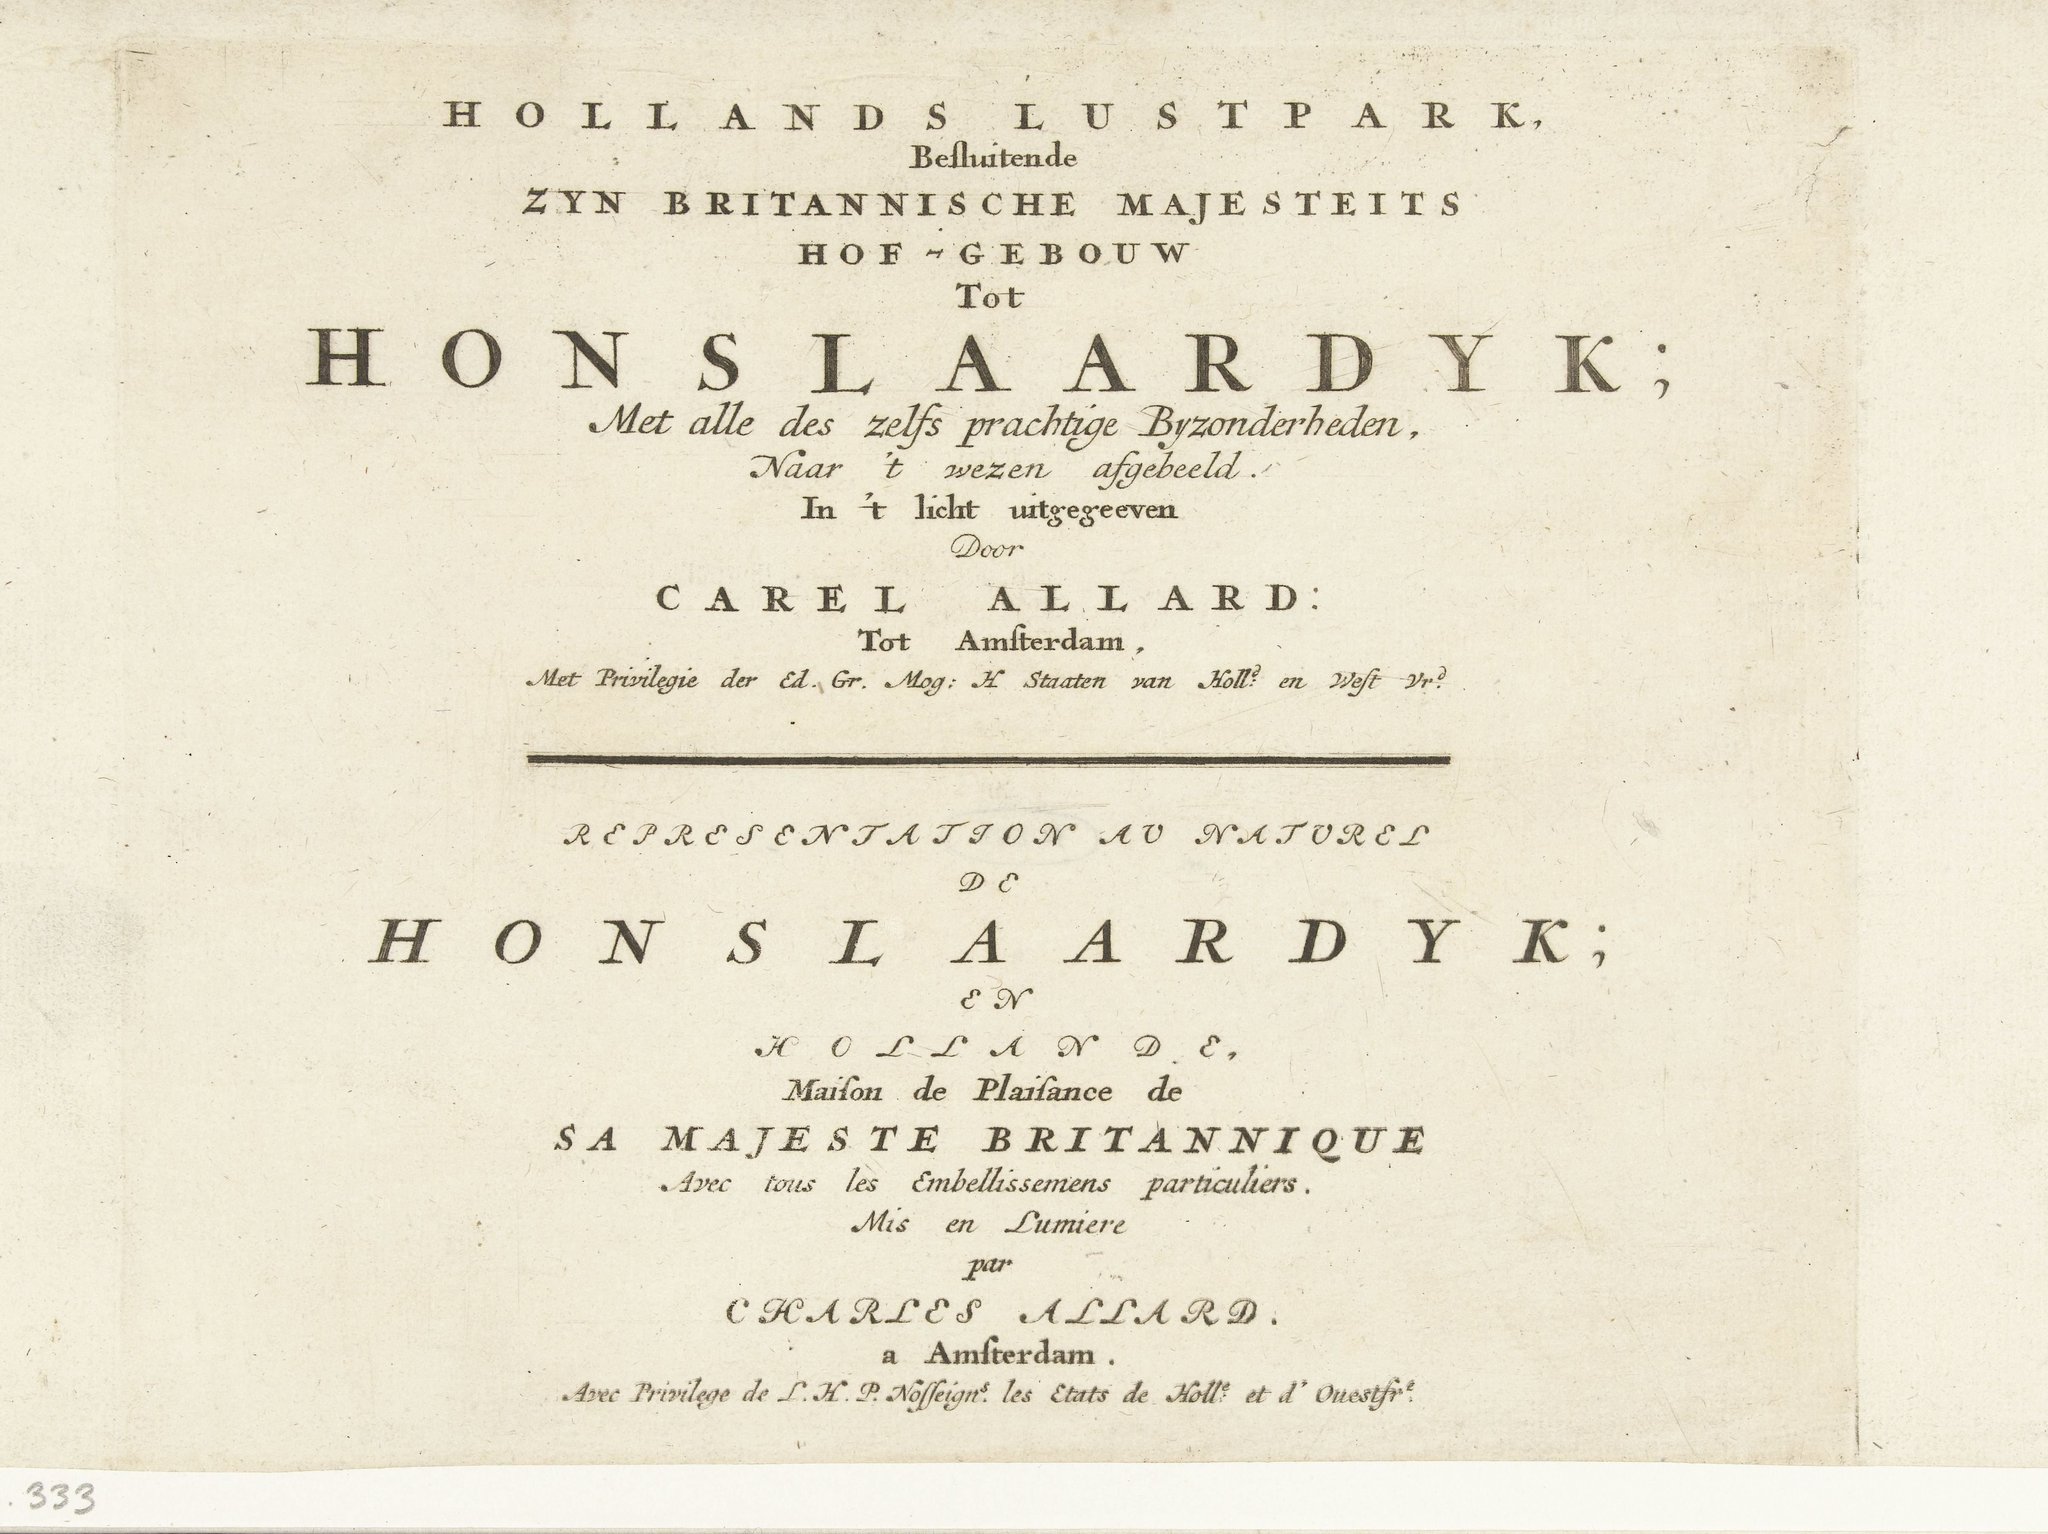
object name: print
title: Titelpagina voor Hollands Lustpark van Carel Allard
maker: carel allard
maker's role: print maker, publisher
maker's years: 1648-1709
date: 1673-1709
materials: paper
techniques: etching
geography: amsterdam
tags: title-page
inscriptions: collector's mark: Lugt 2228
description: Titel van het werk in het Nederlands en het Frans